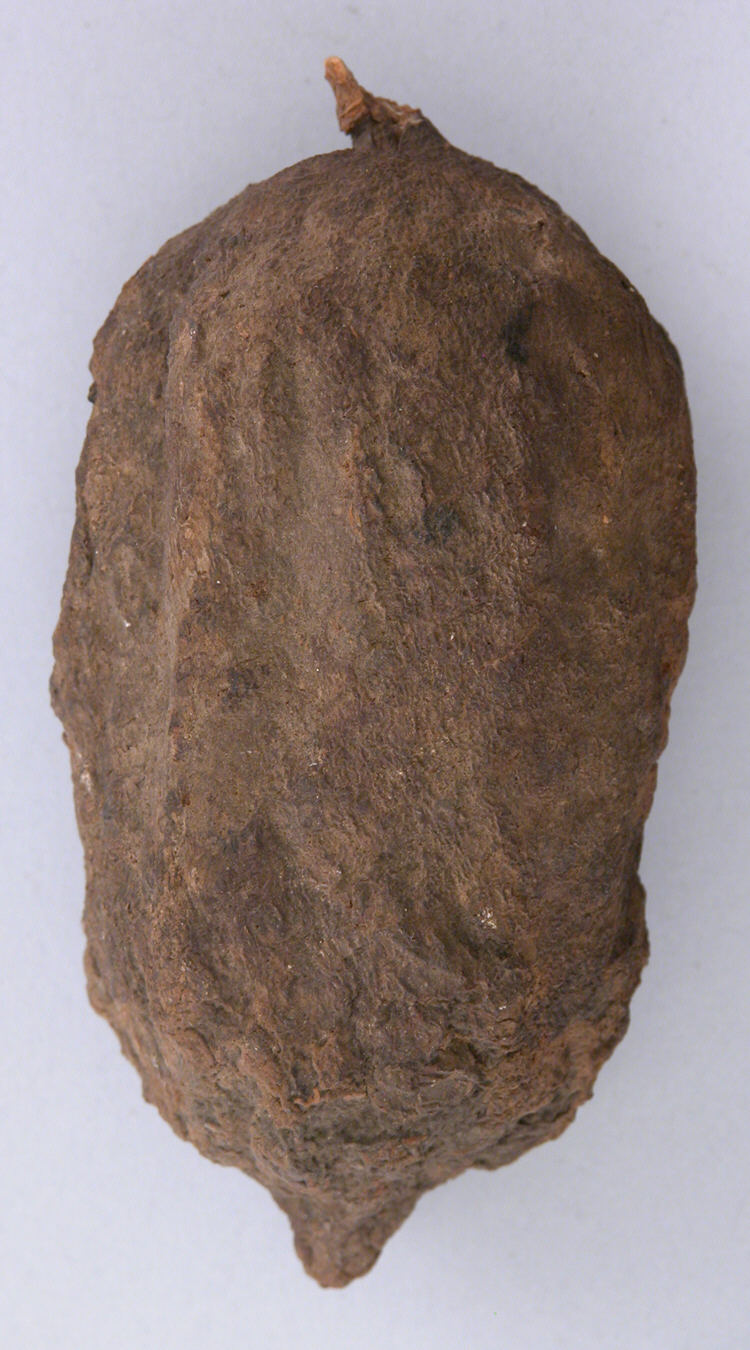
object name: petrified lemon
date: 201-1200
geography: egypt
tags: lemons